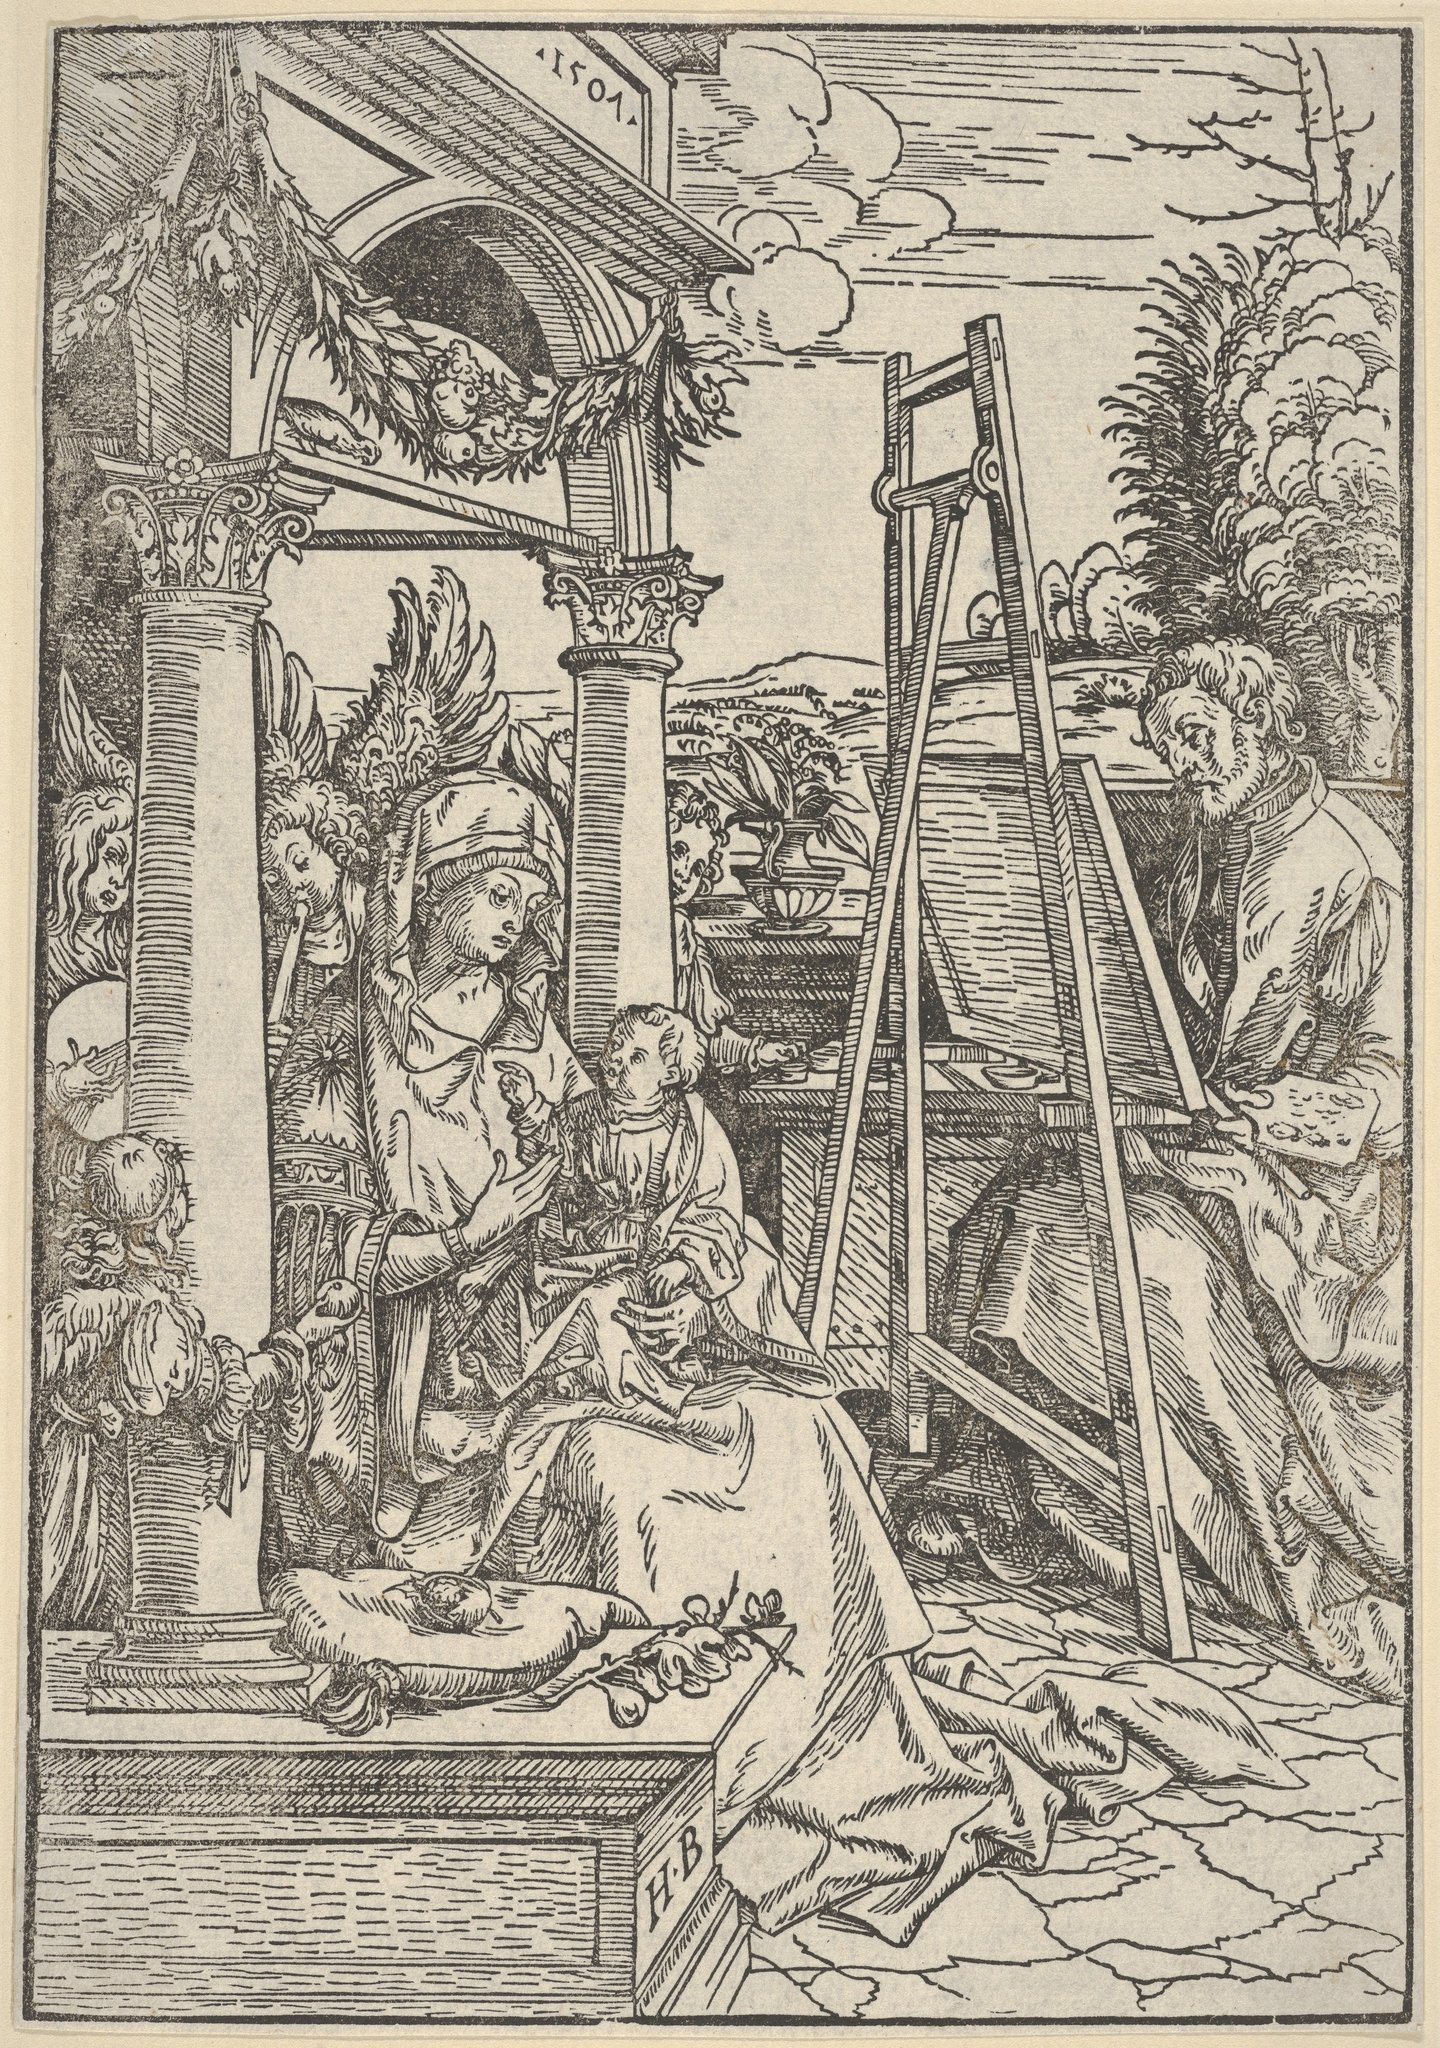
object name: print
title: Saint Luke Painting the Virgin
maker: hans burgkmair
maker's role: artist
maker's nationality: german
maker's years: 1473-1531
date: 1507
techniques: woodcut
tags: painting,men,angels,madonna and child,saints